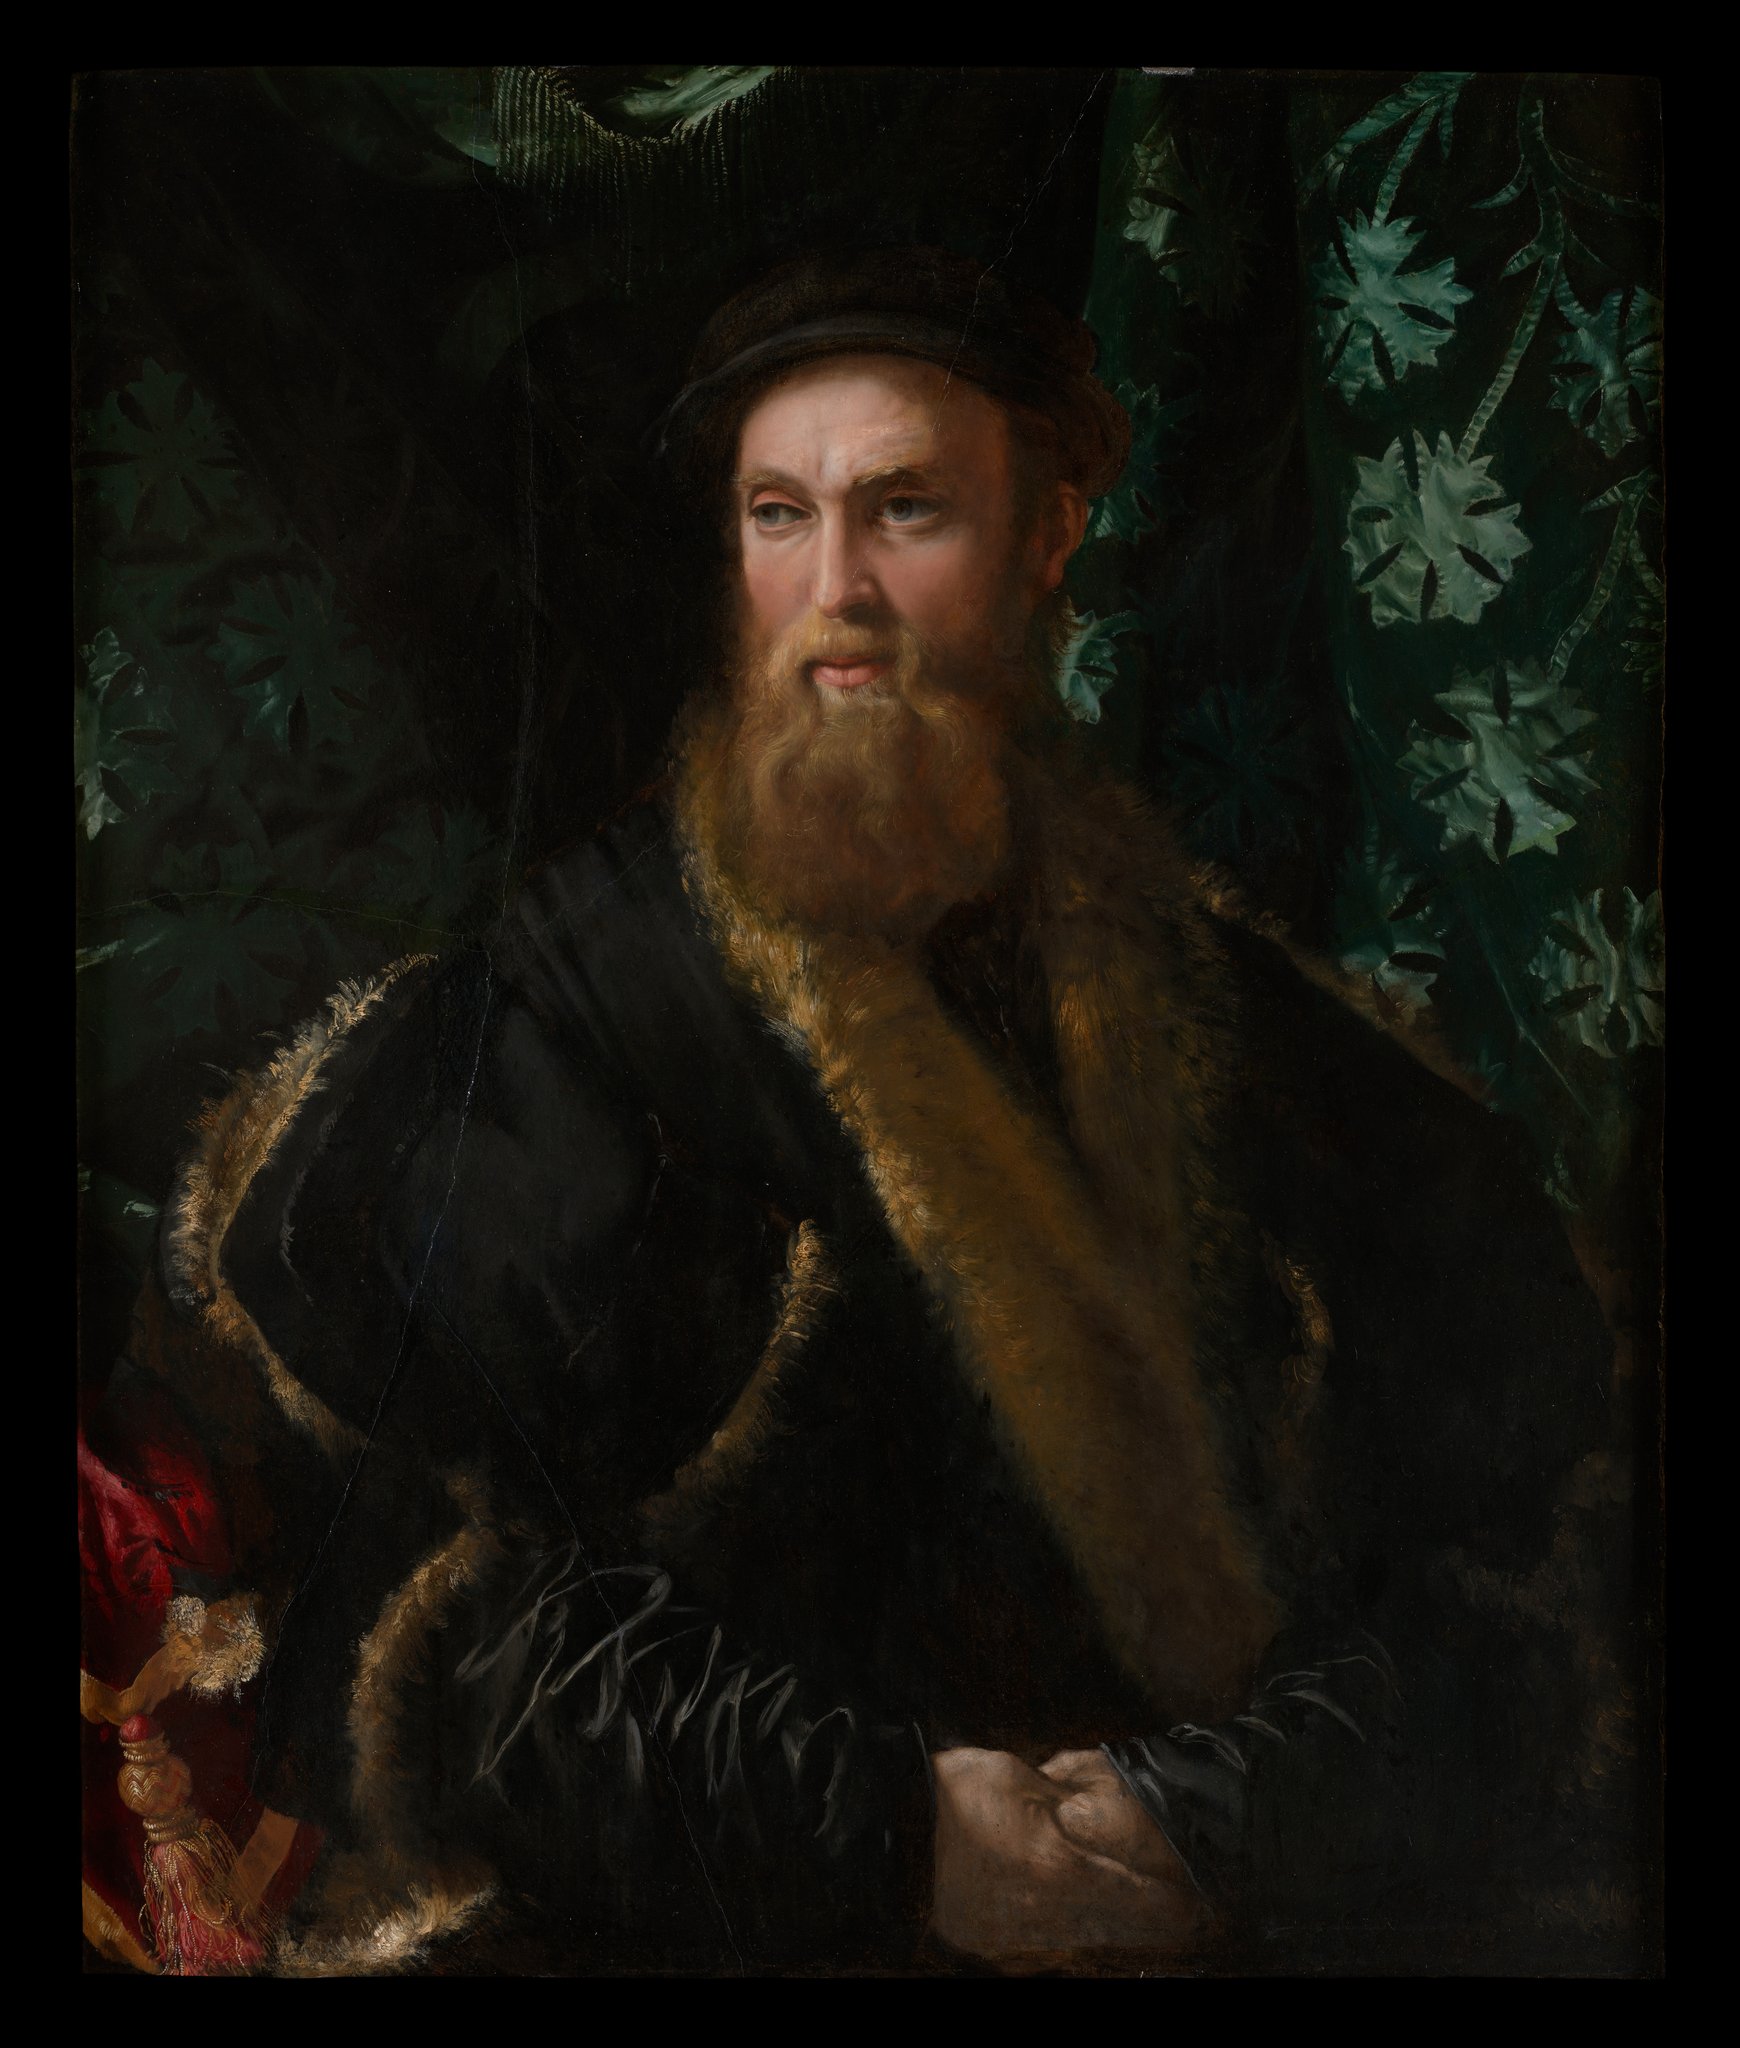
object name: painting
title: Bindo Altoviti (1491–1557)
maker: francesco salviati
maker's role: artist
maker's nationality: italian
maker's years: 1510-1563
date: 1545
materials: marble, oil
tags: men,portraits